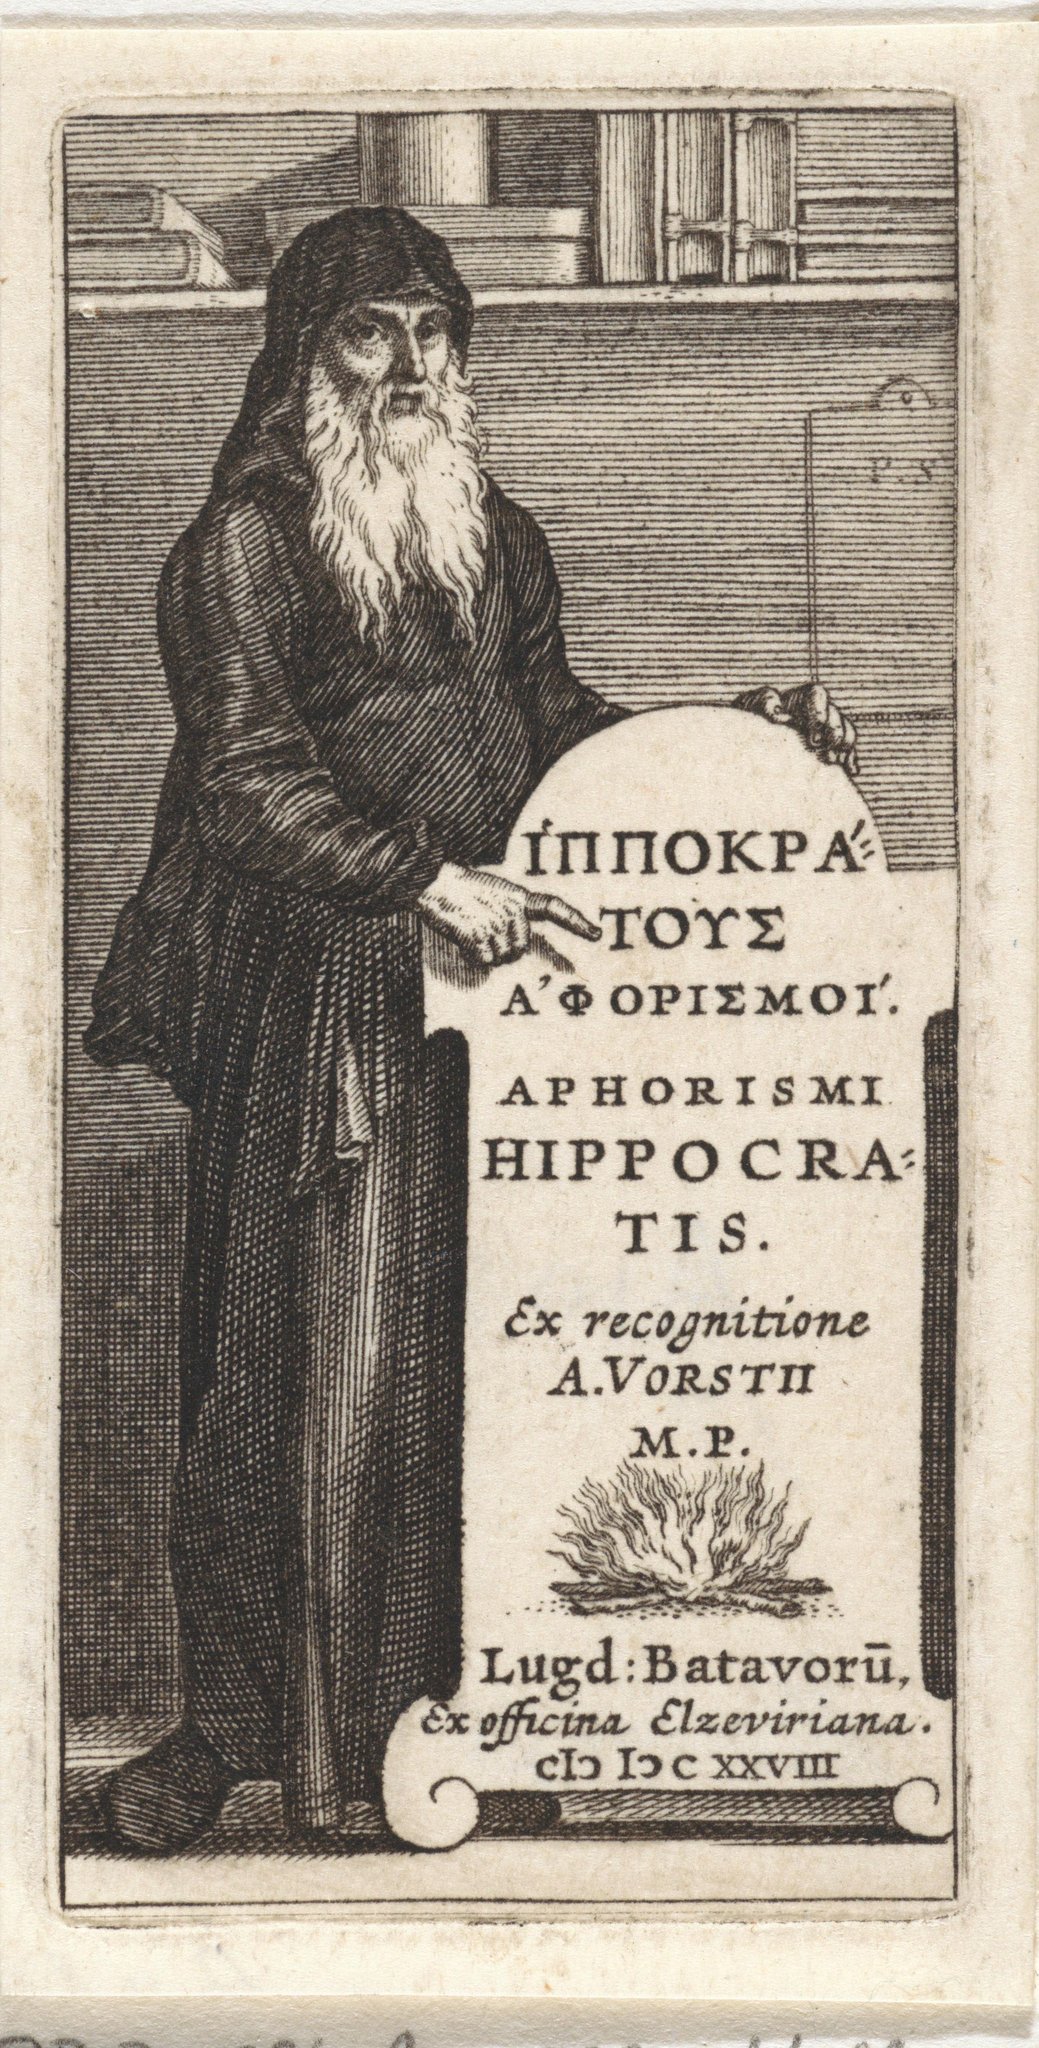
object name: print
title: Hippocrates van Kos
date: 1628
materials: paper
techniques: engraving, etching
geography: leiden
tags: writing tablets, bookshelves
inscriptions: collector's mark: Lugt 2227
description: Een oude man met baard, voorstellende Hippocrates, houdt een tablet vast met daarop de titel, auteur en bezorger van het boek in het Latijn en Grieks. Daaronder het impressum. Achter Hippocrates aan de muur een boekenplank en een schrijftablet.